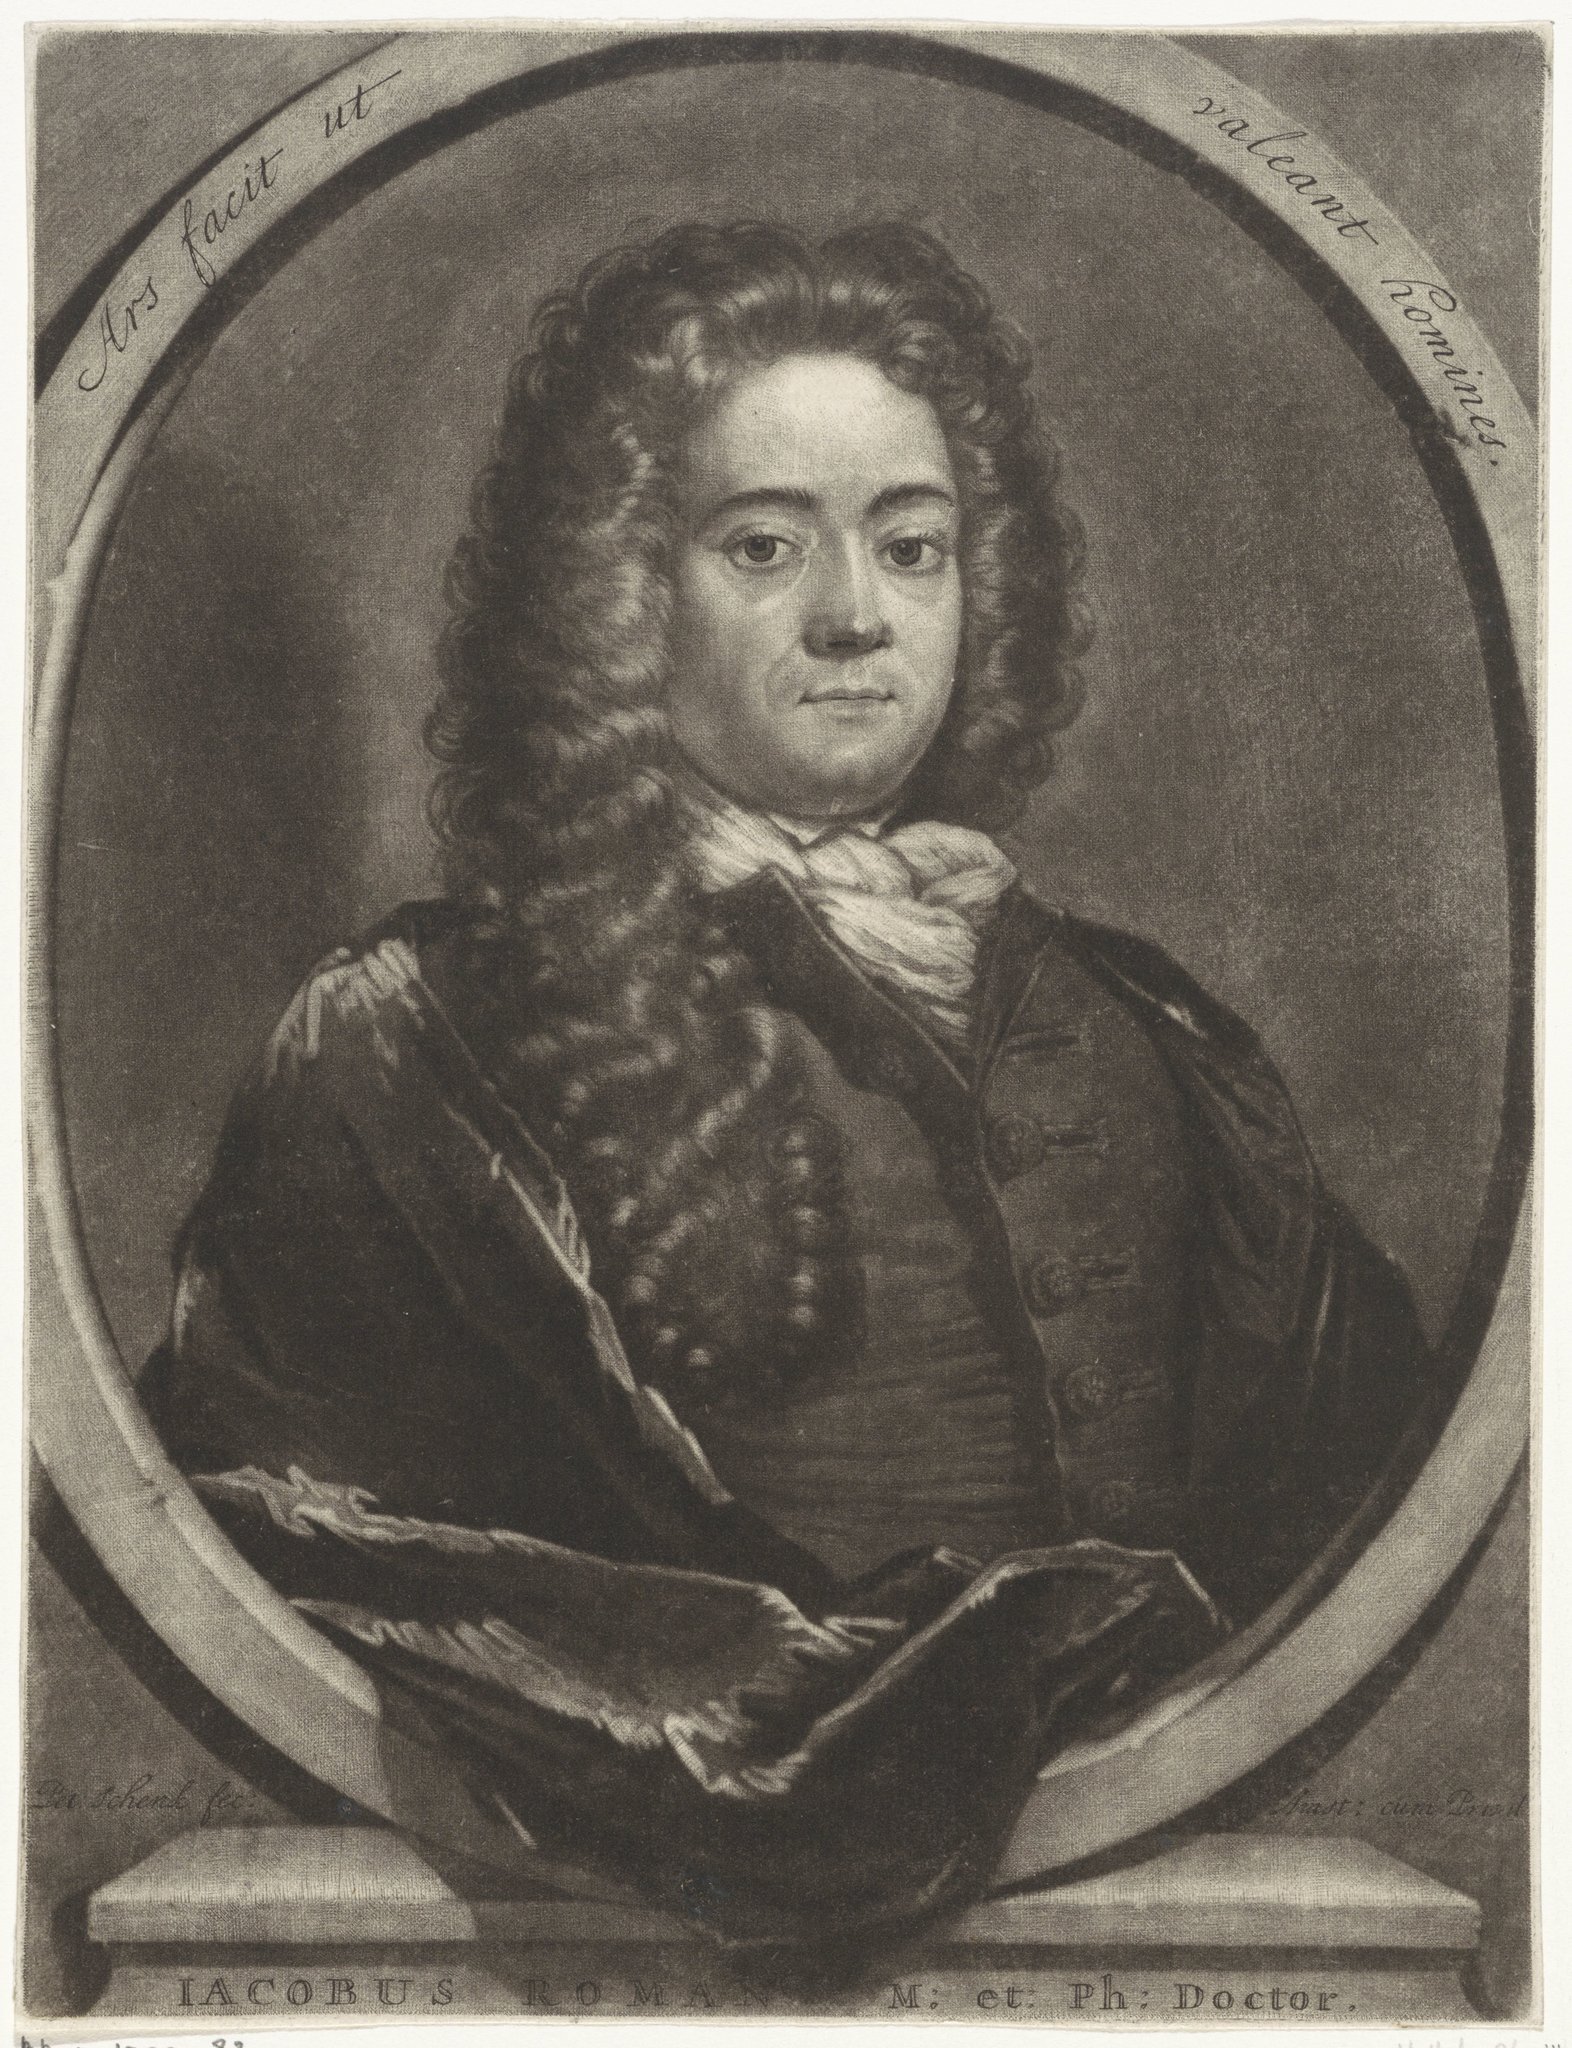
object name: print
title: Portret van de arts Jacob Roman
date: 1670-1713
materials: paper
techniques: engraving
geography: amsterdam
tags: wig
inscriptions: collector's mark: Lugt 2165